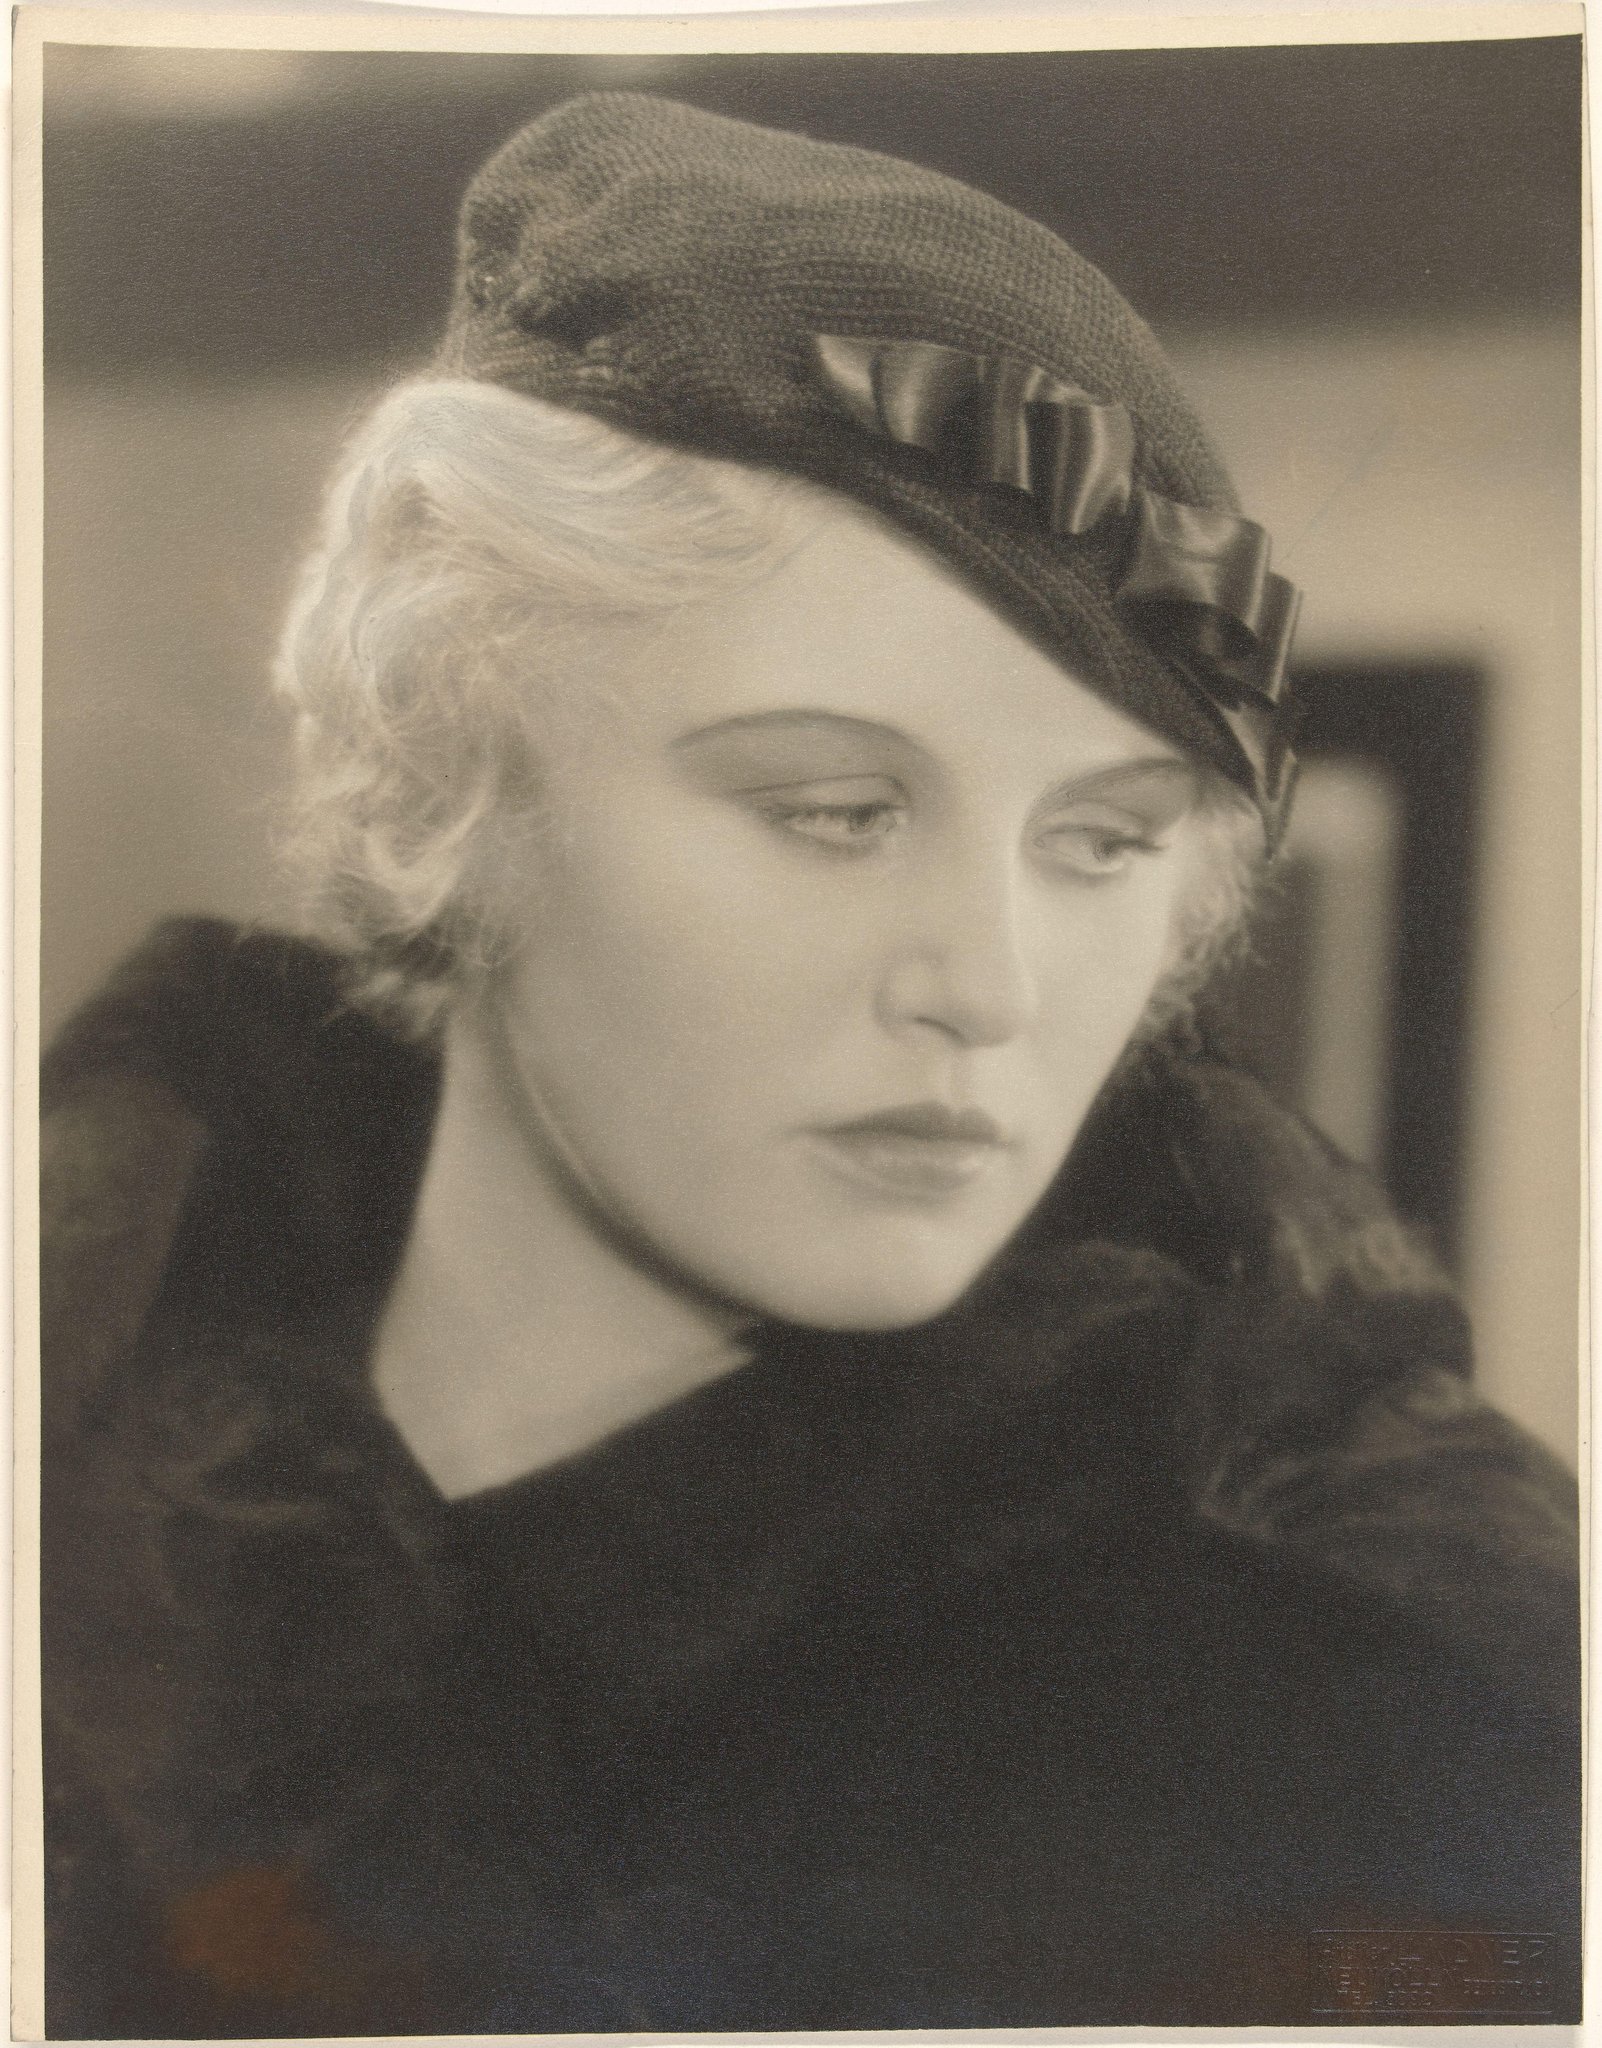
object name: photograph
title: Portret van actrice Camilla Spira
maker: lindner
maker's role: fotograaf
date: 1930-1950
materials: photographic support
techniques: gelatin silver print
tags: berlin